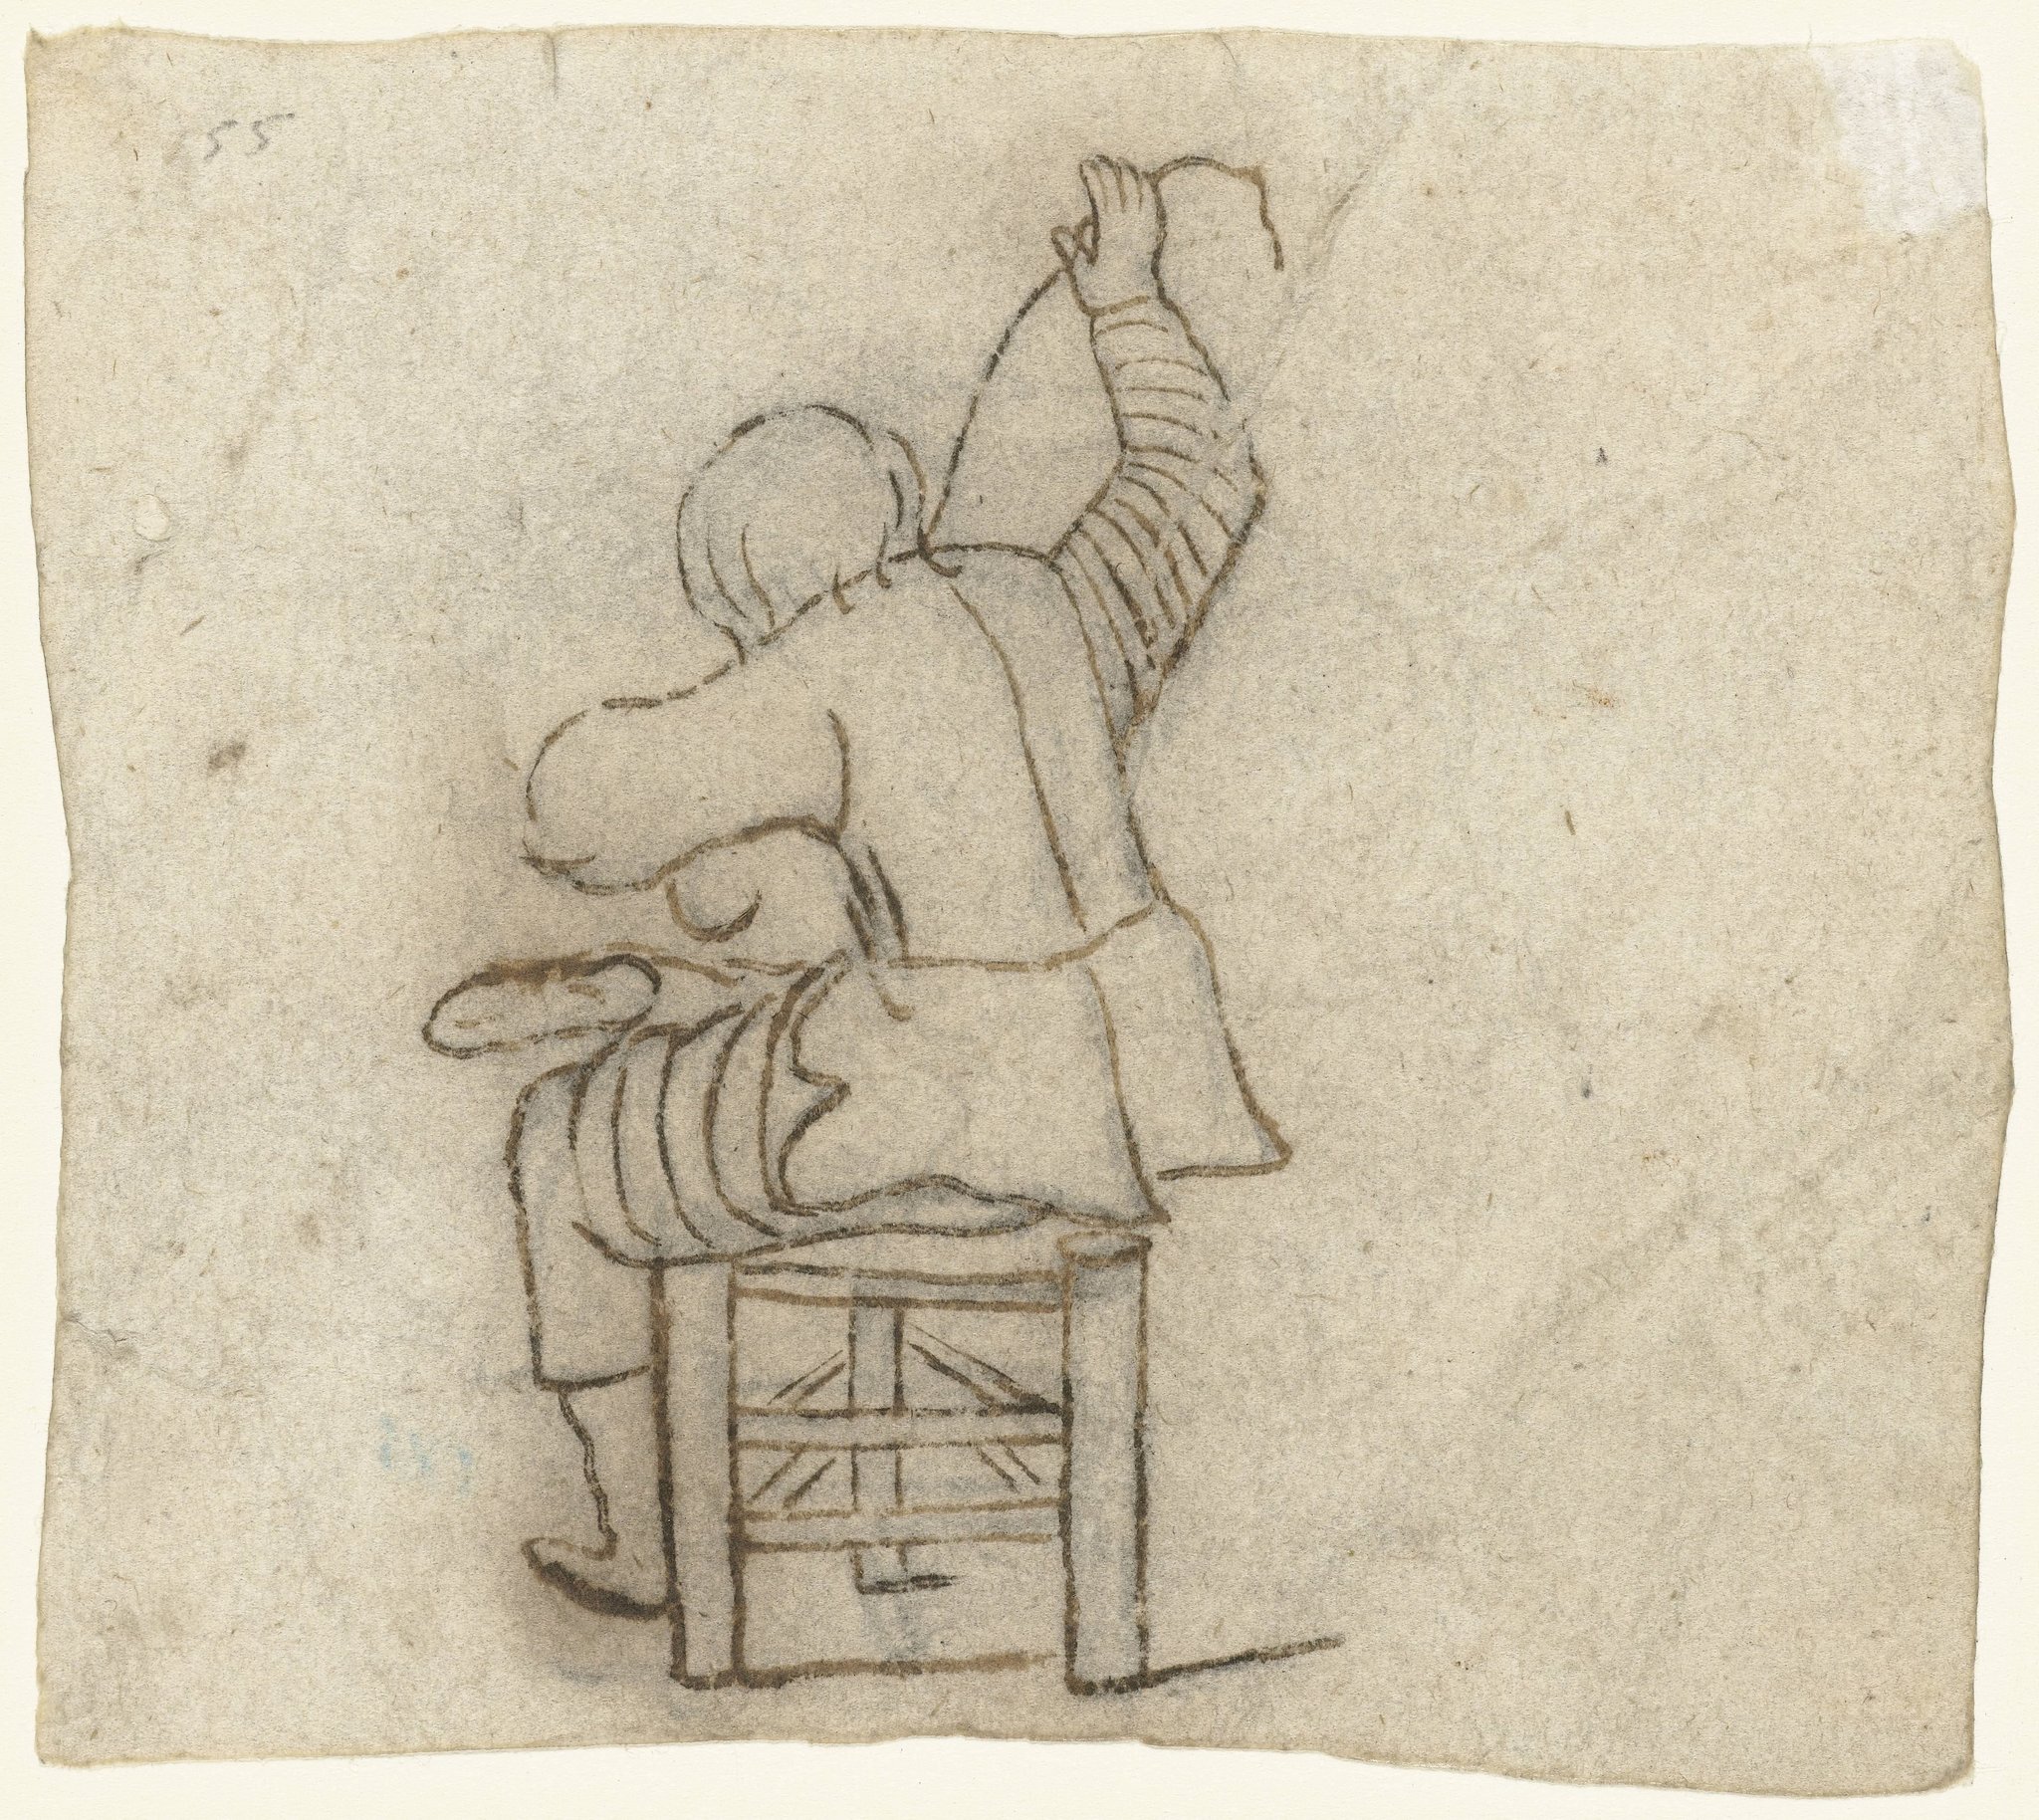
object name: drawing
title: Kleermaker op een kruk, van achteren gezien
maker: harmen ter borch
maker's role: draughtsman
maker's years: 1638-1677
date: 1648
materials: chalk, ink, paper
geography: zwolle